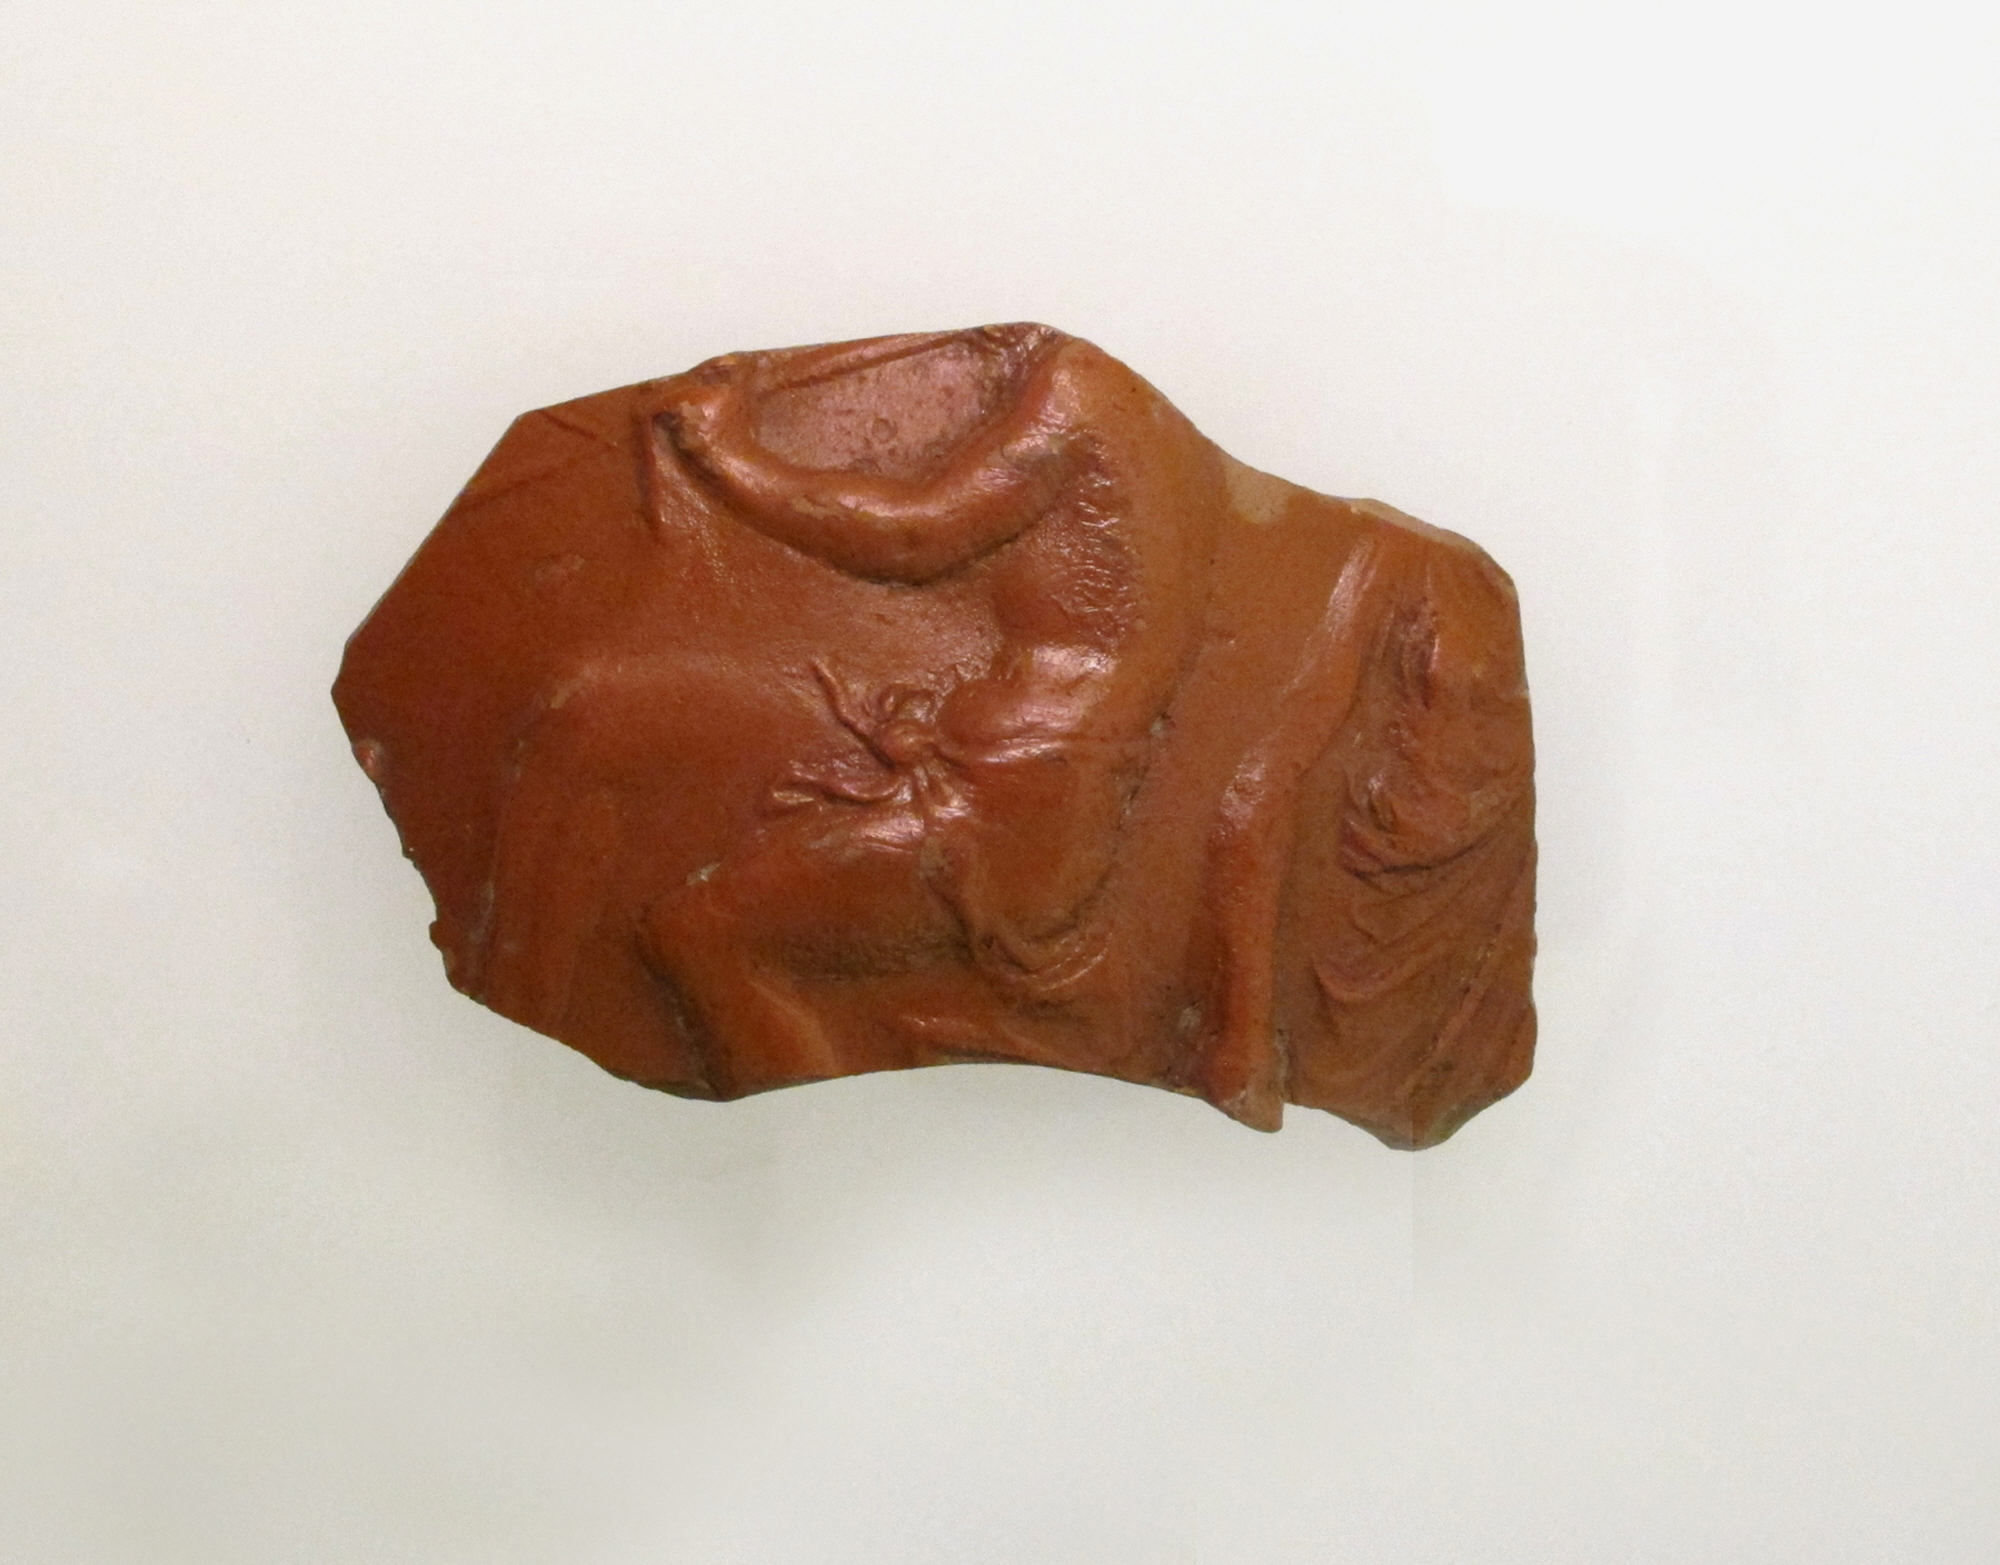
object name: vase fragment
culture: roman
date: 670 BCE-330 CE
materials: terracotta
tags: women,flutes,satyrs